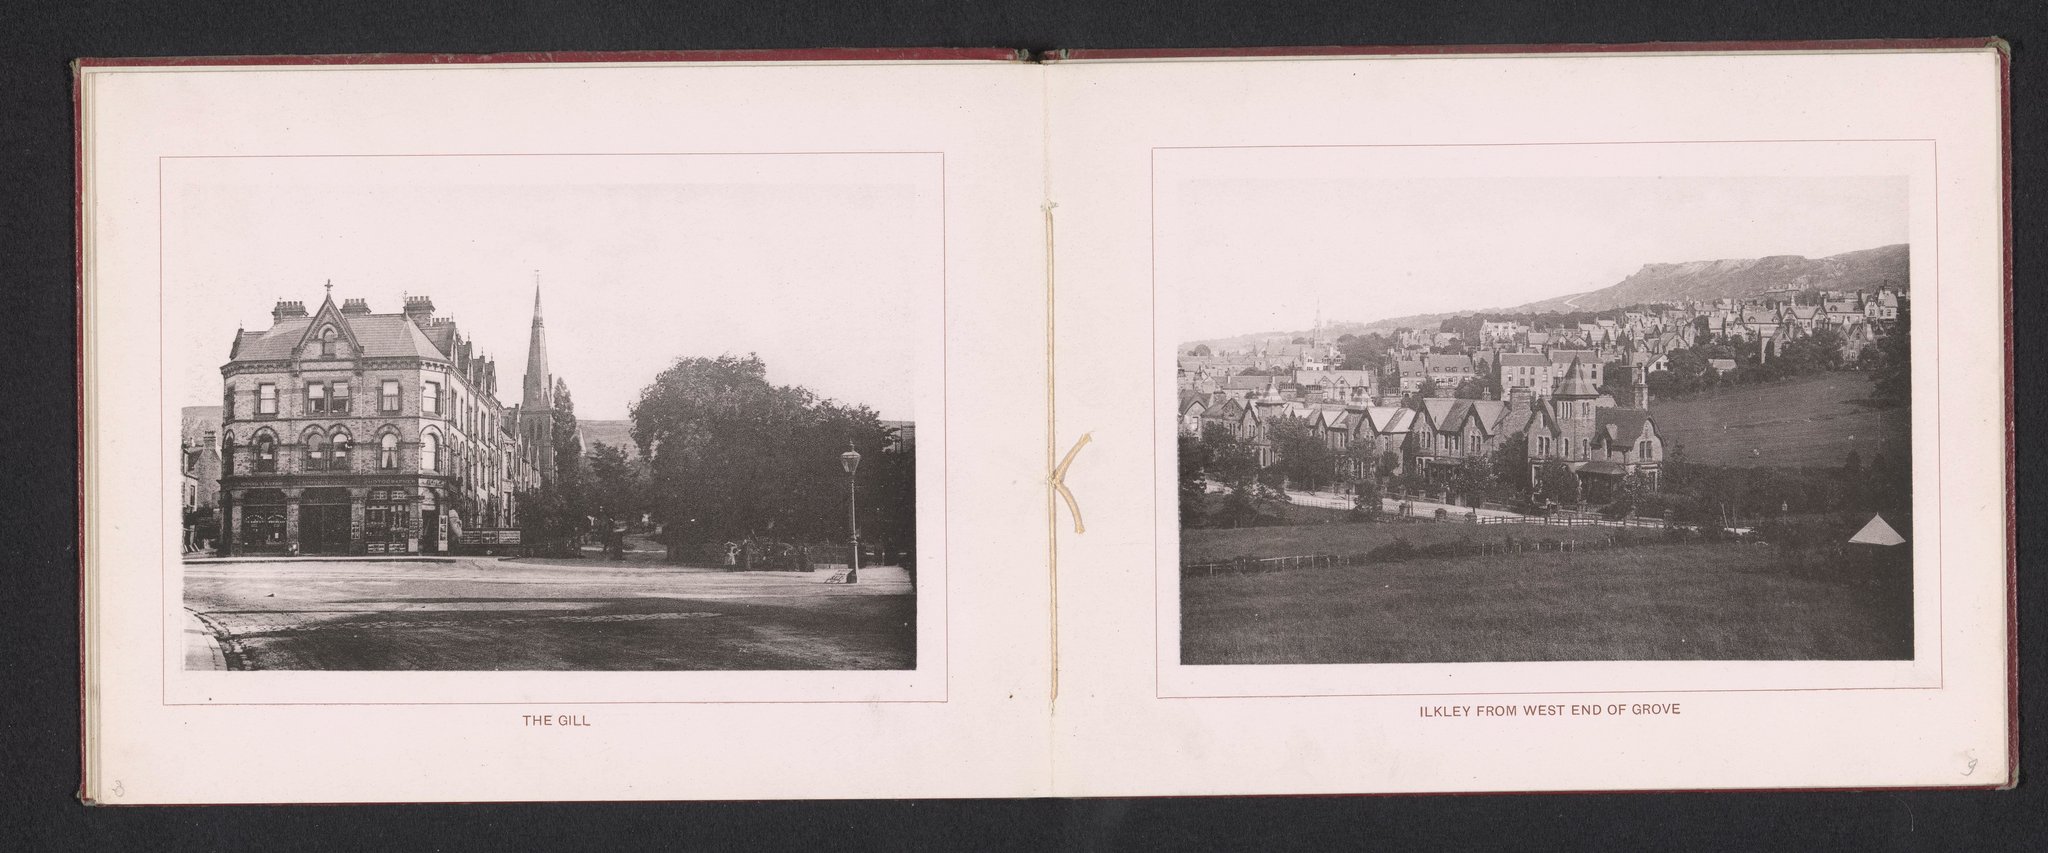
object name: page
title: Ilkley from West end of grove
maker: Anonymous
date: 1890-1900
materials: paper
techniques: photograph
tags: prospect of city, town panorama, silhouette of city